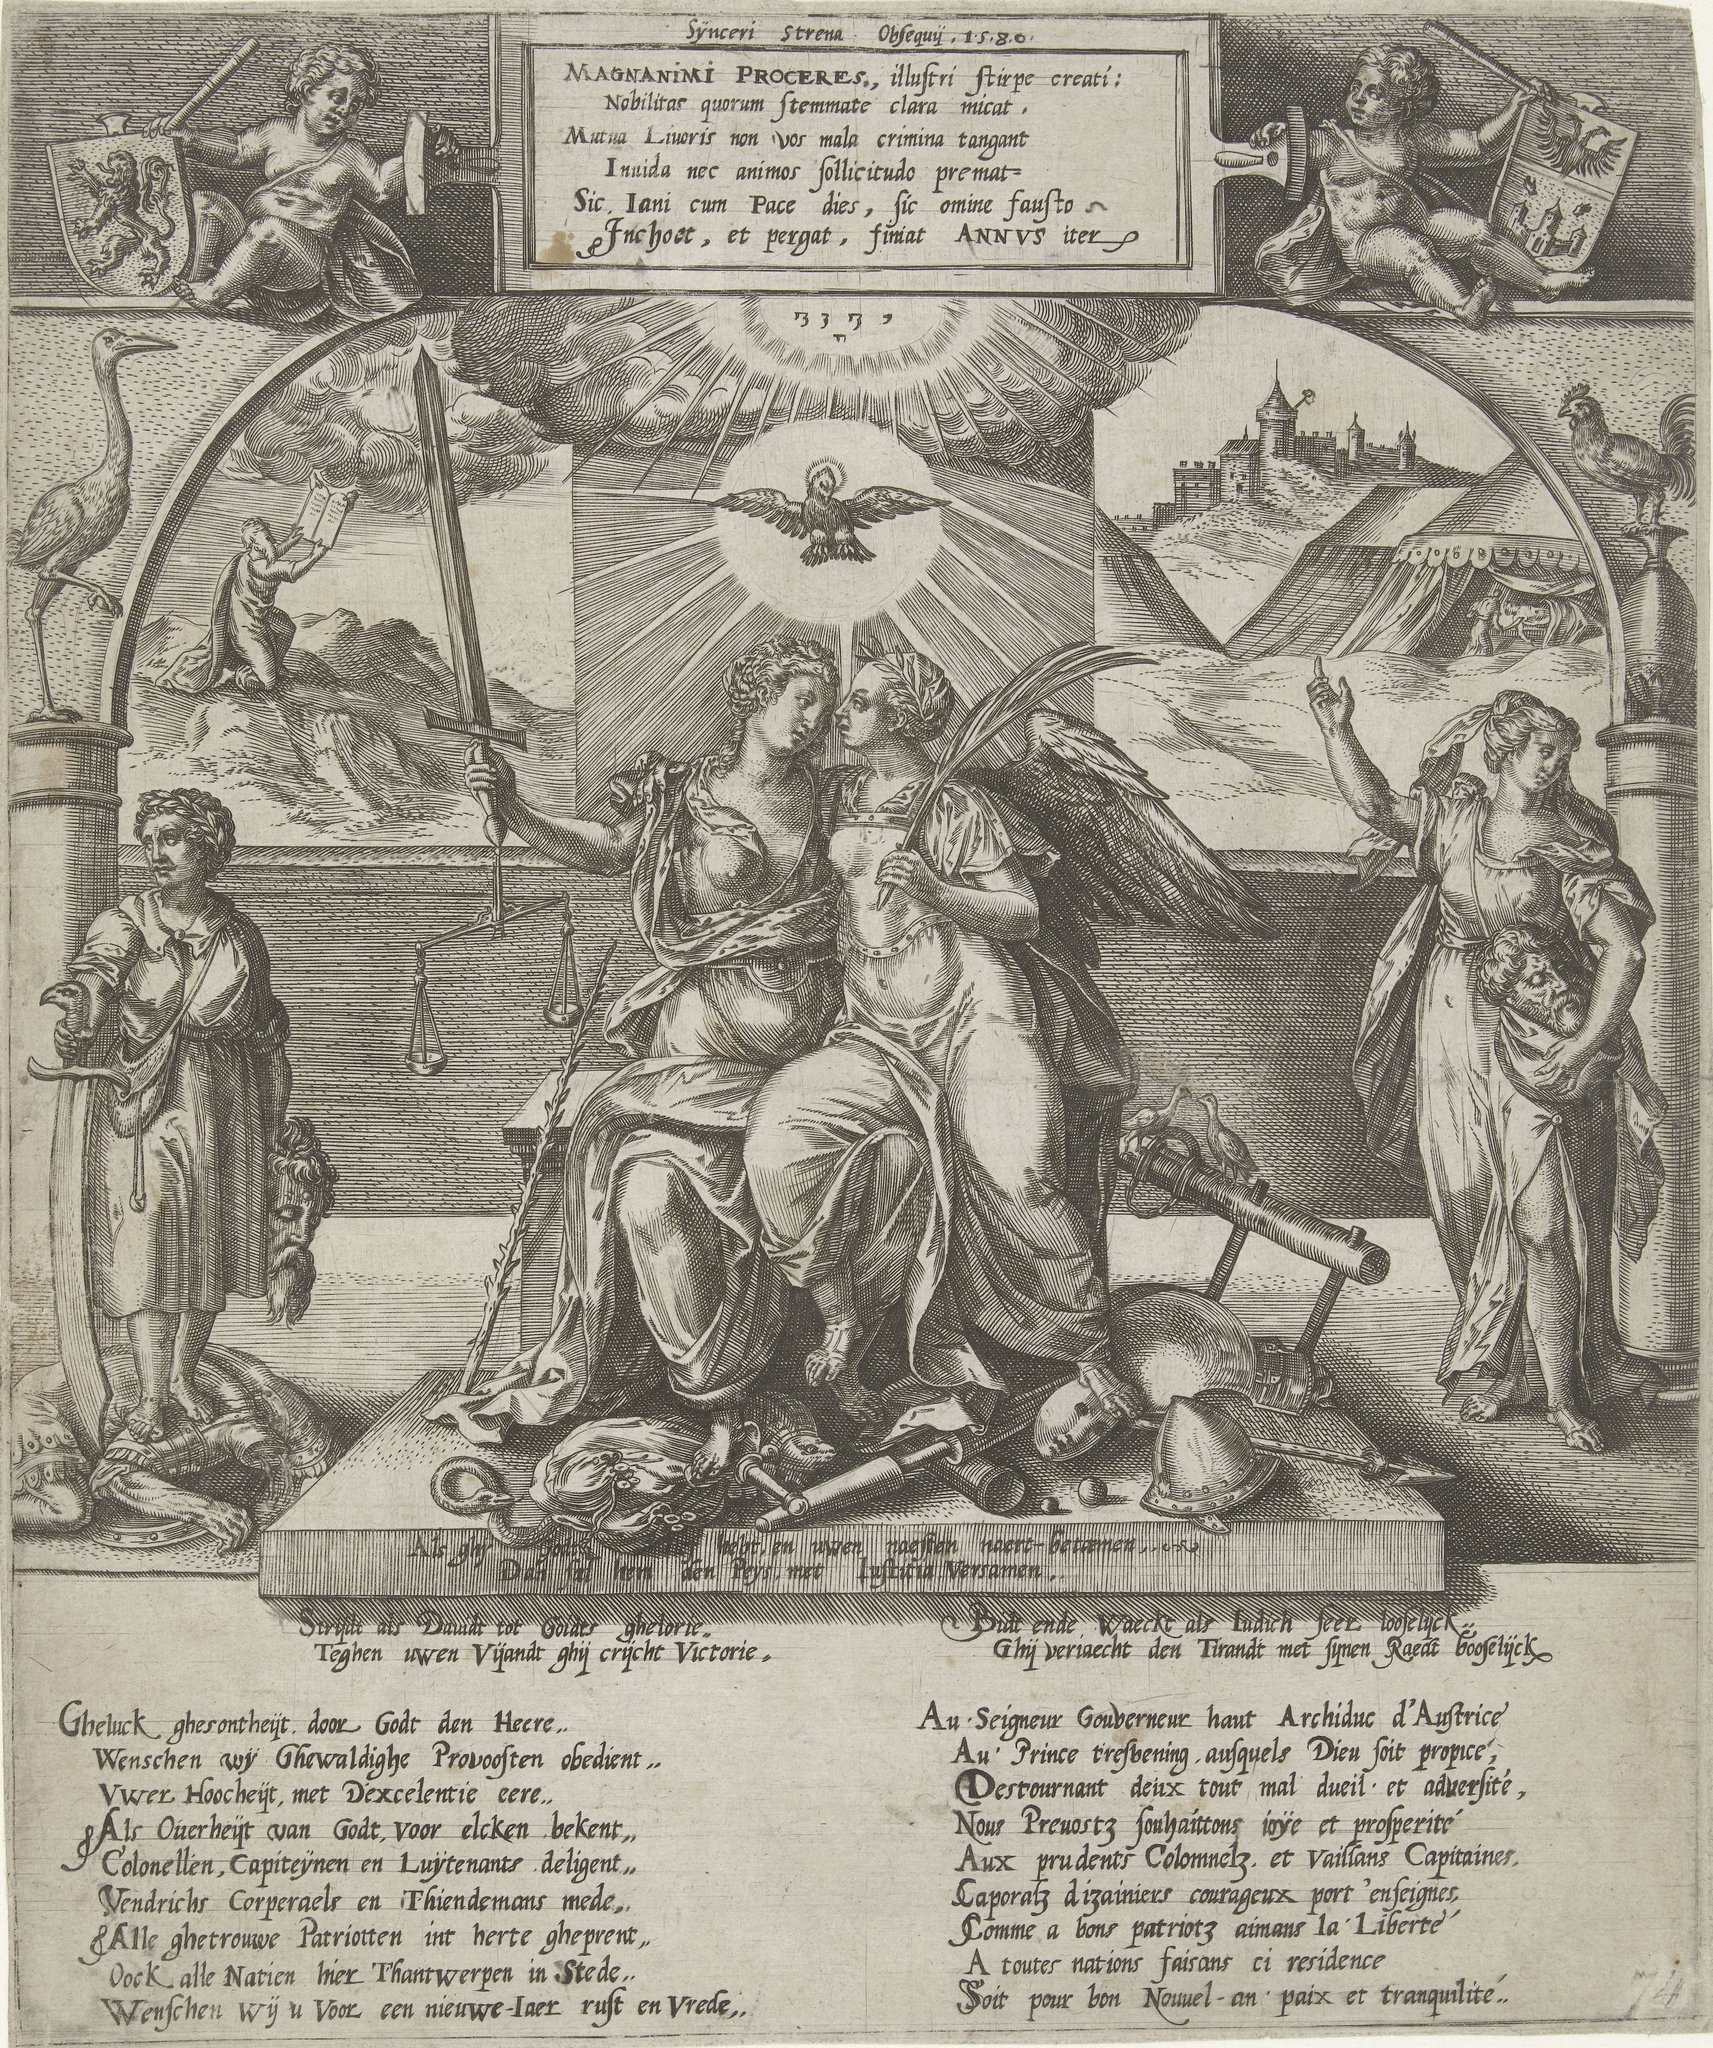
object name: print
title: Nieuwjaarswens voor aartshertog Matthias, 1580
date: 1579-1580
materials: paper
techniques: engraving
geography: southern netherlands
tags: vienna, matthias van oostenrijk (rooms-duits keizer), david with goliath's head, justice, 'justitia'; 'giustitia divina' (ripa) ~ one of the four cardinal virtues, symbols, allegories of peace, 'pax'; 'pace' (ripa), judith shows holofernes' head to the people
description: Nieuwjaarswens voor aartshertog Matthias, van de provoosten van Antwerpen voor het jaar 1580. Allegorie met Rechtvaardigheid en Vrede die elkaar omhelzen, aan hun voeten symbolen van de oorlog. Links David met het hoofd van Goliath, rechts Judith met het hoofd van Holofernes. Bovenaan in een cartouche een tekst van 6 regels in het Latijn, onderaan 2 verzen van elk 2 en 9 regels in het Nederlands en Frans.